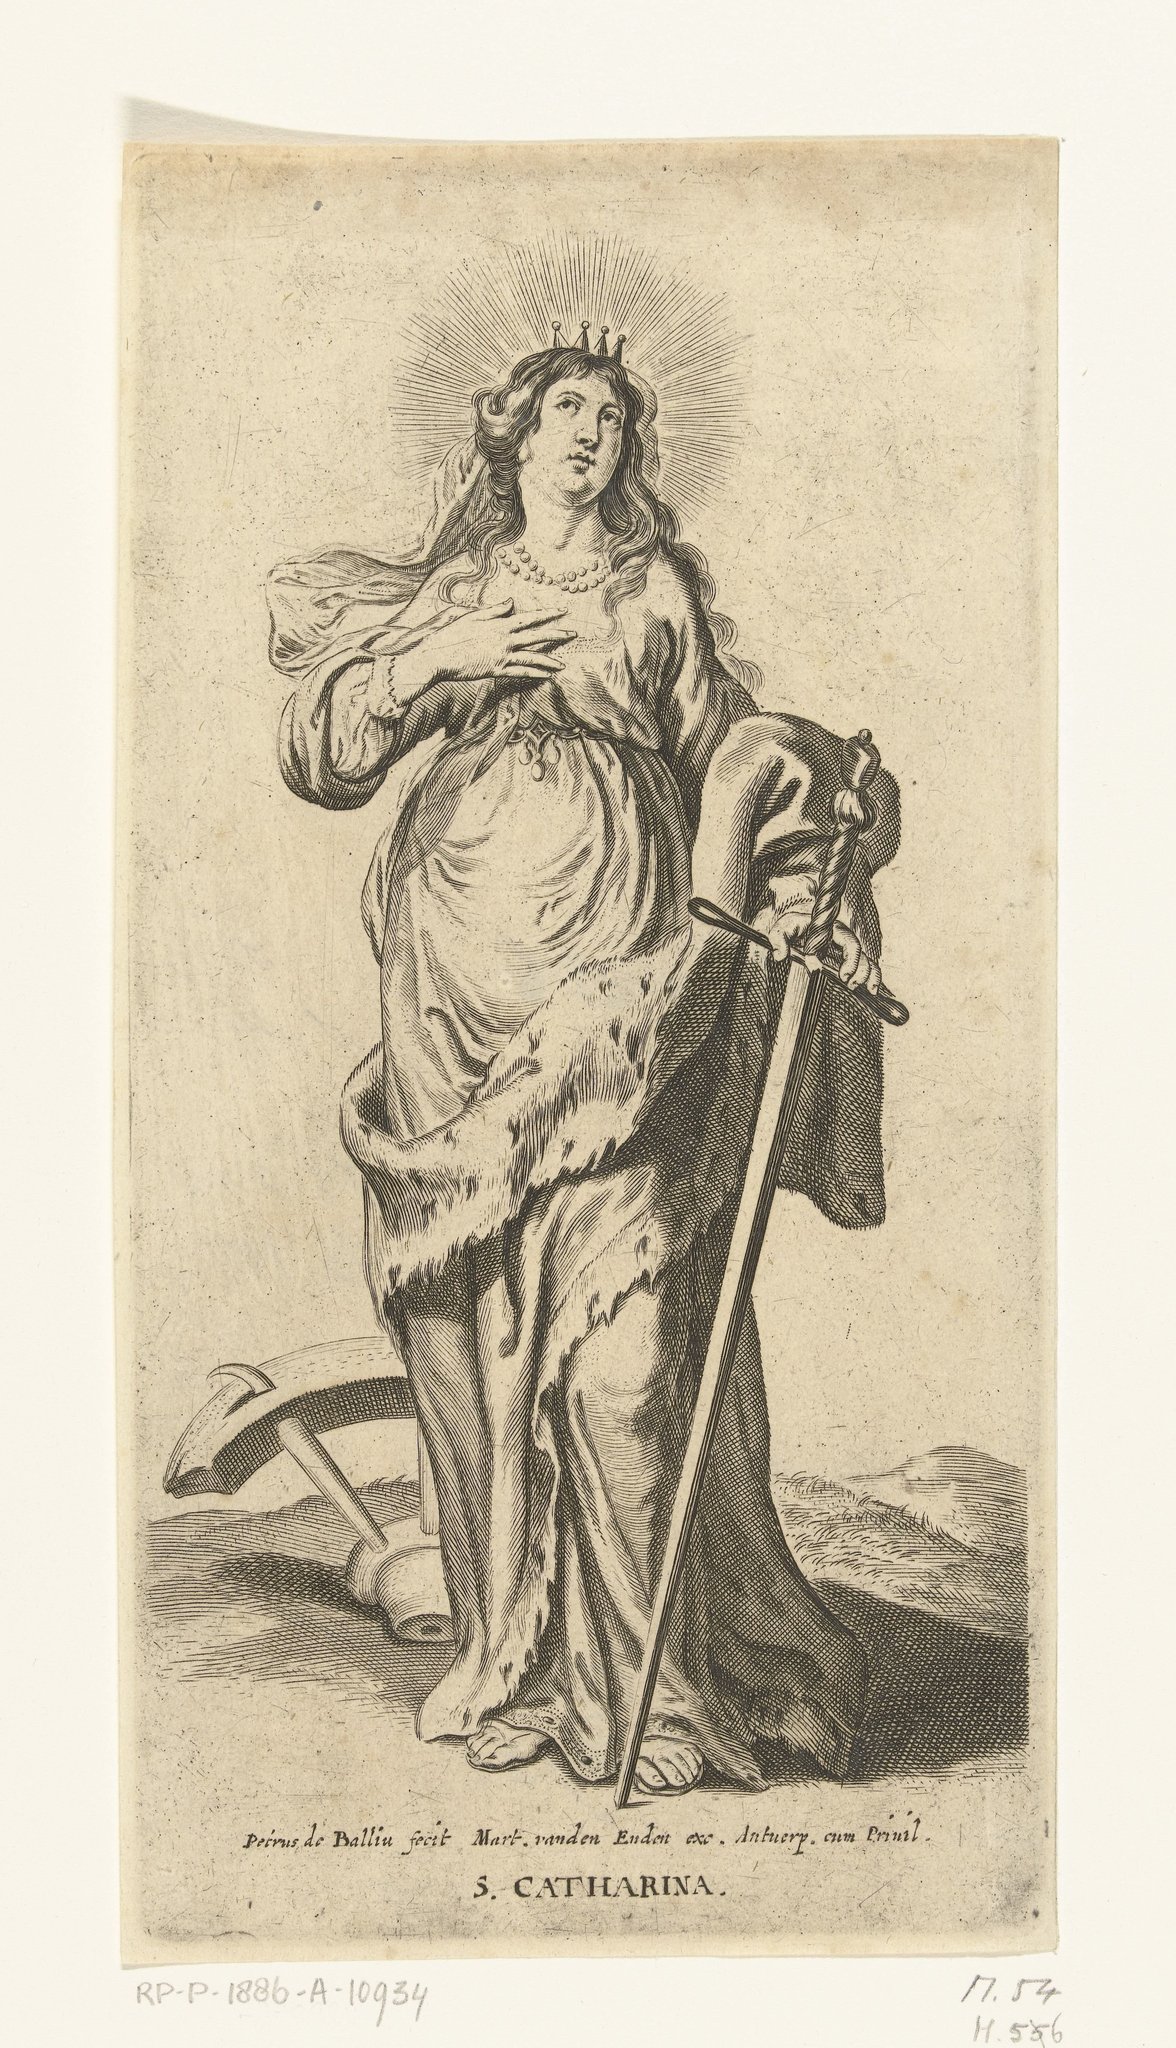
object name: print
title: Heilige Catharina van Alexandrië met gebroken wiel en zwaard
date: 1623-1660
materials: paper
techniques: engraving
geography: antwerp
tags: the virgin martyr catherine of alexandria; possible attributes: book, crown, emperor maxentius, palm-branch, ring, sword, wheel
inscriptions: collector's mark: Lugt 2228